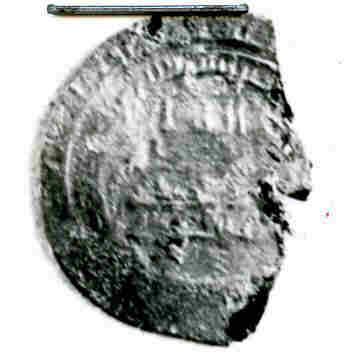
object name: coin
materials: copper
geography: iran